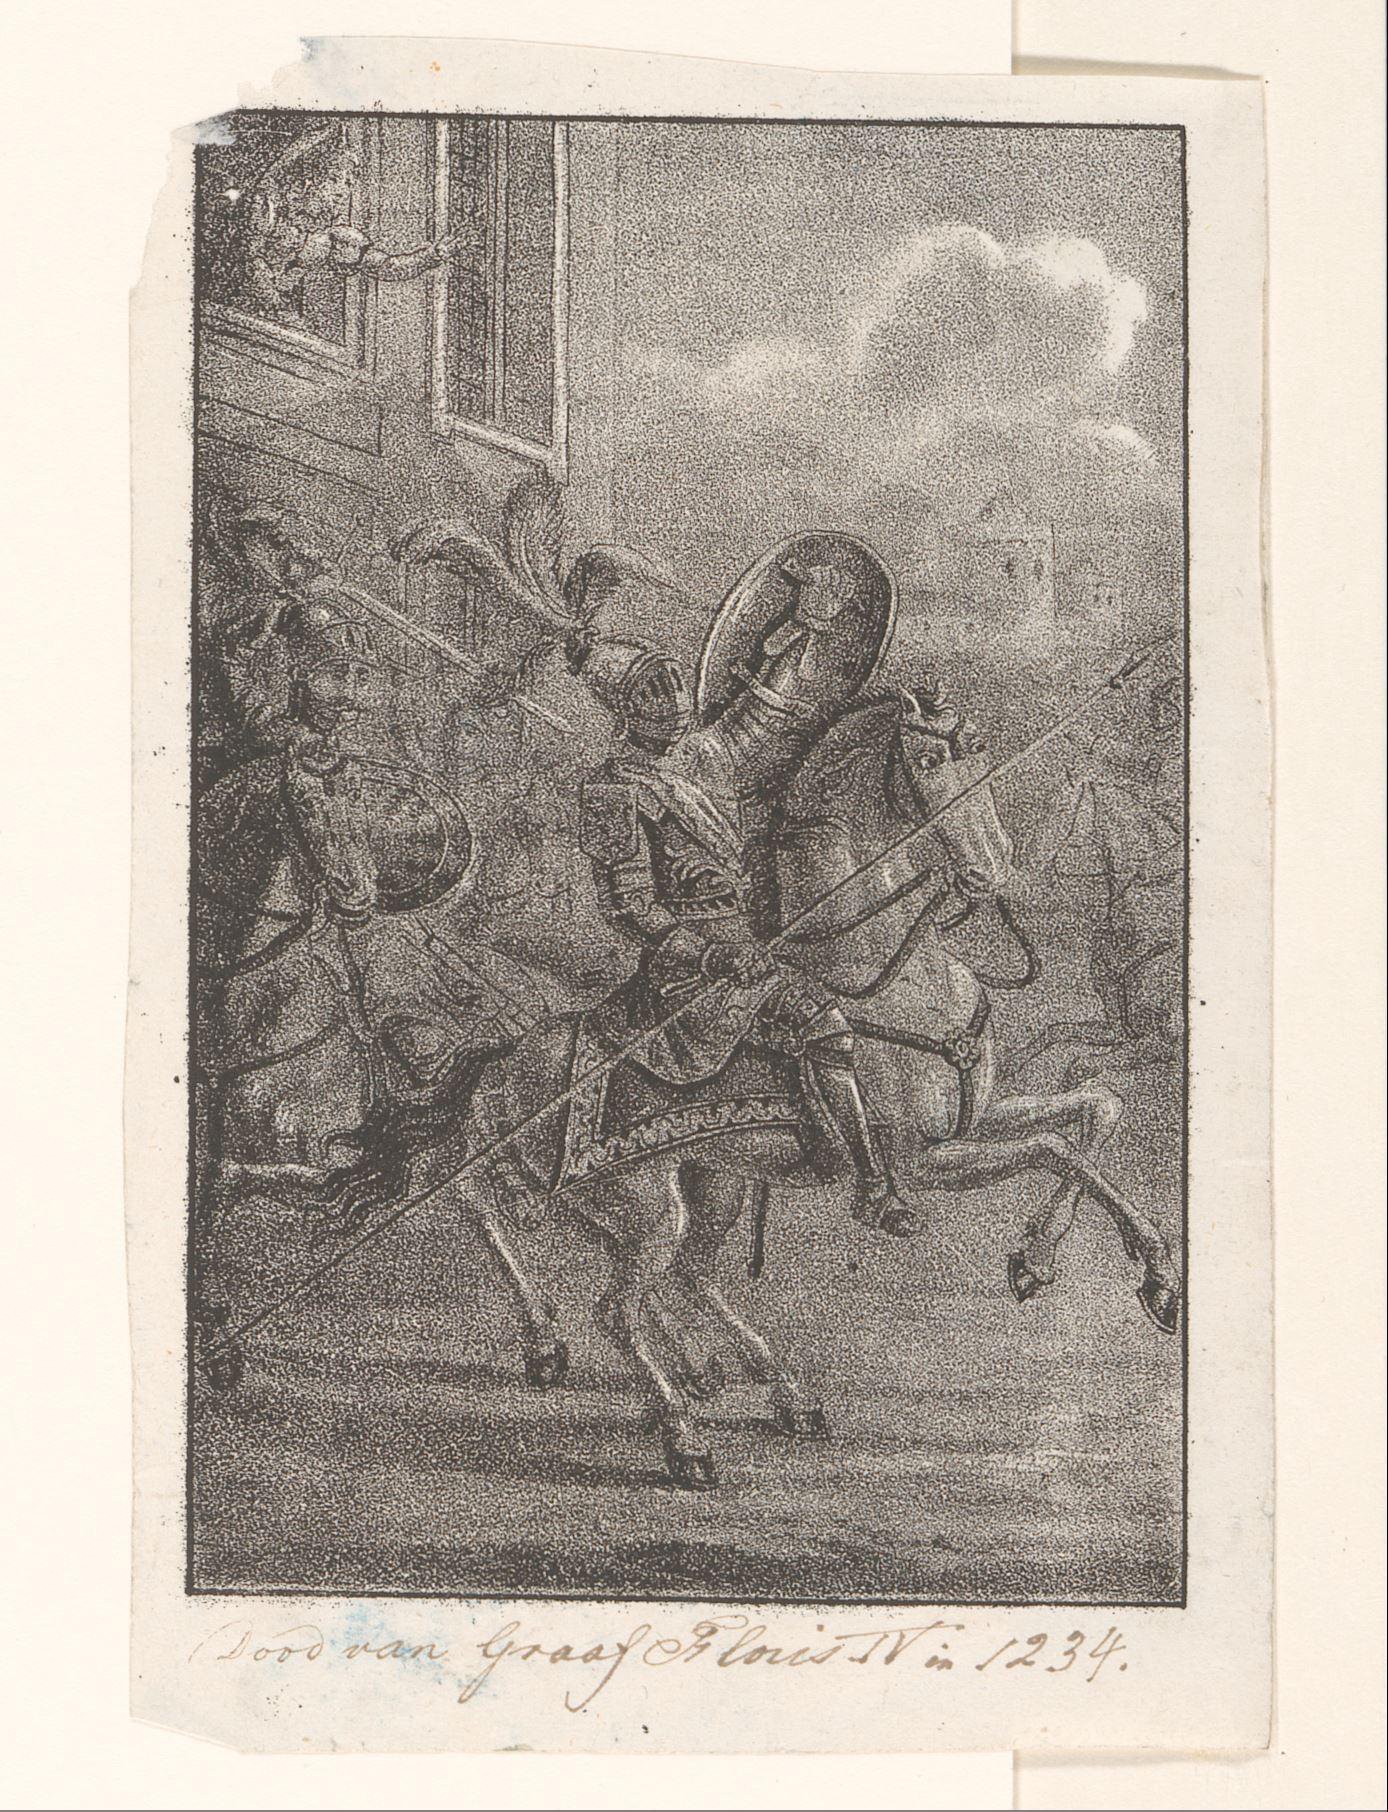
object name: print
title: Graaf Floris IV tijdens het toernooi in Corbie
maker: Anonymous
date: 1809-1899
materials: paper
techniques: lithograph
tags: tournament, knight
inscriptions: collector's mark: Lugt 2228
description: Tijdens het toernooi werd graaf Floris IV in de val gelokt door de jaloerse graaf van Clermont. Zijn vrouw, zichtbaar in het raam, zou een liefdesbrief aan Floris IV hebben verstuurd. Tijdens het toernooi stak hij hem dood.